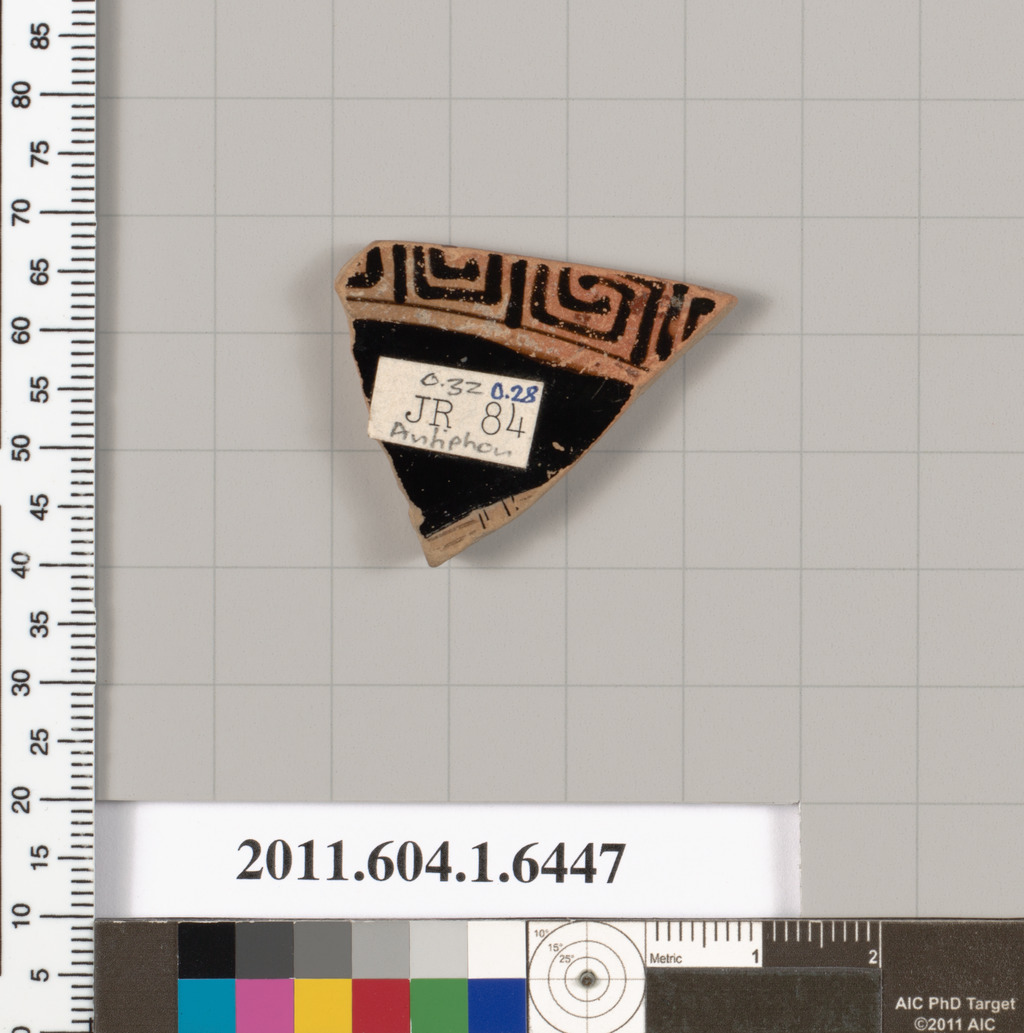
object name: kylix fragment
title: Terracotta fragment of a kylix (drinking cup)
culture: greek, attic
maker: antiphon painter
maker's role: artist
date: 490-480 BCE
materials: terracotta